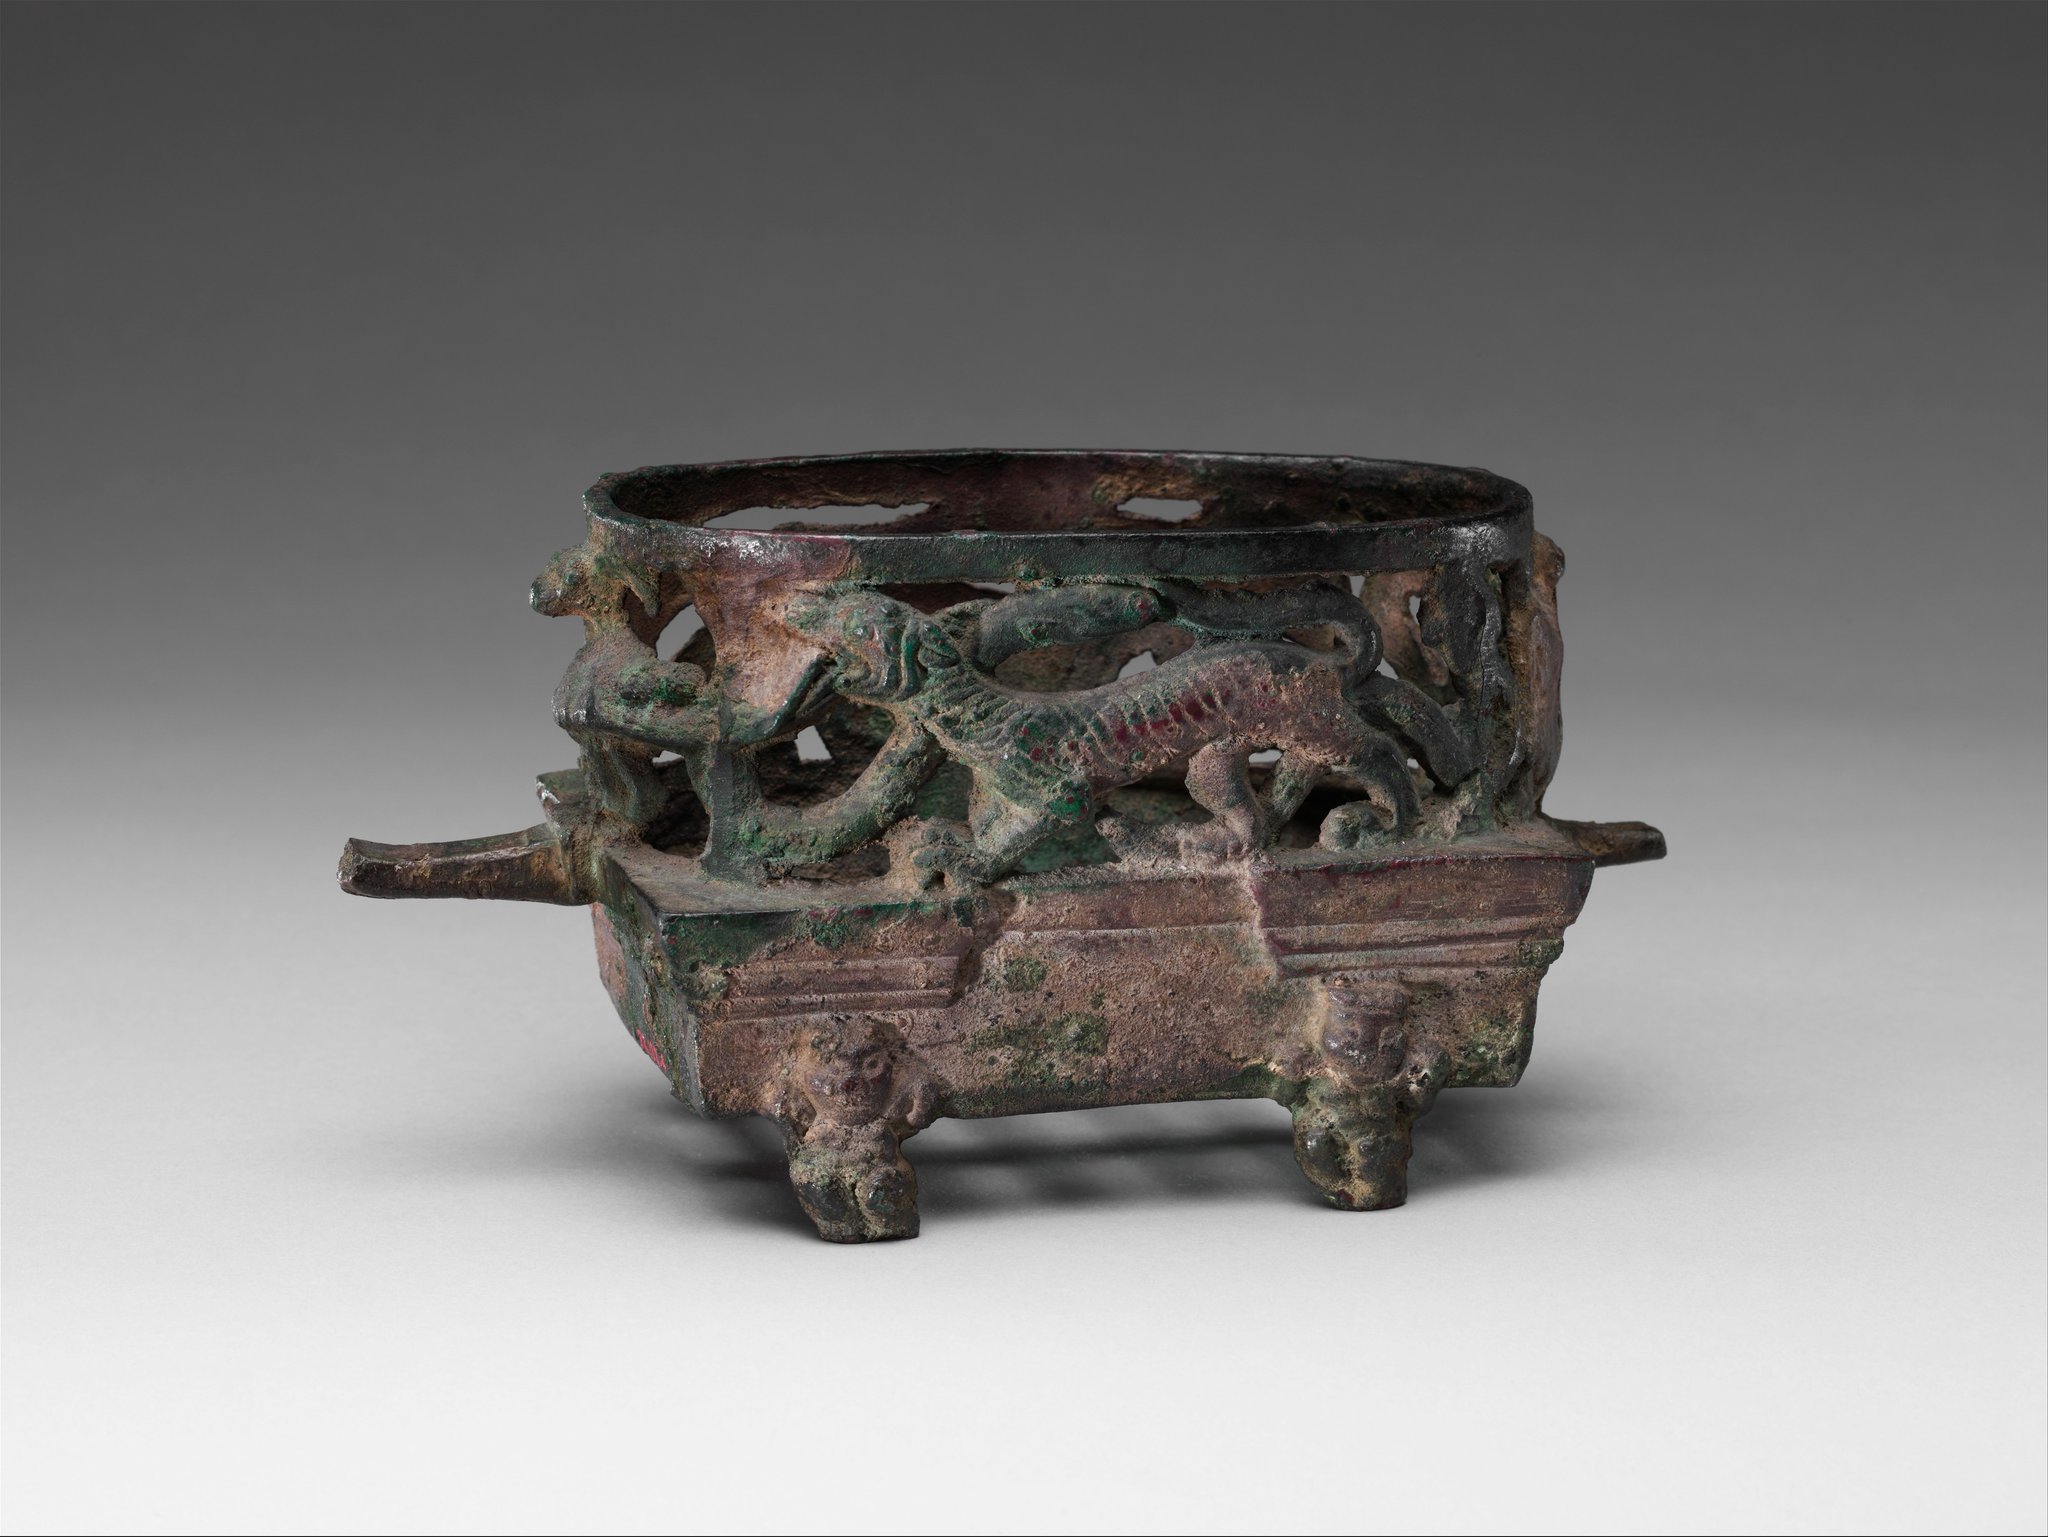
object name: burner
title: Burner (Ran Lu)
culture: chinese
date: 200-1 BCE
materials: bronze